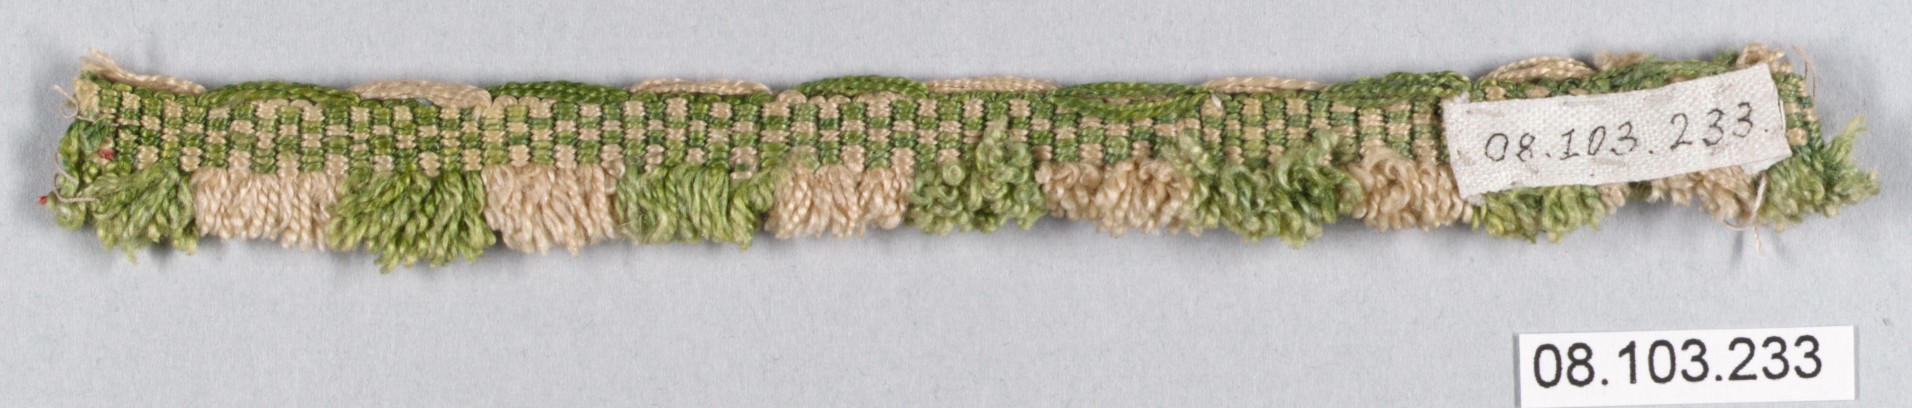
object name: gimp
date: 1701-1800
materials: silk